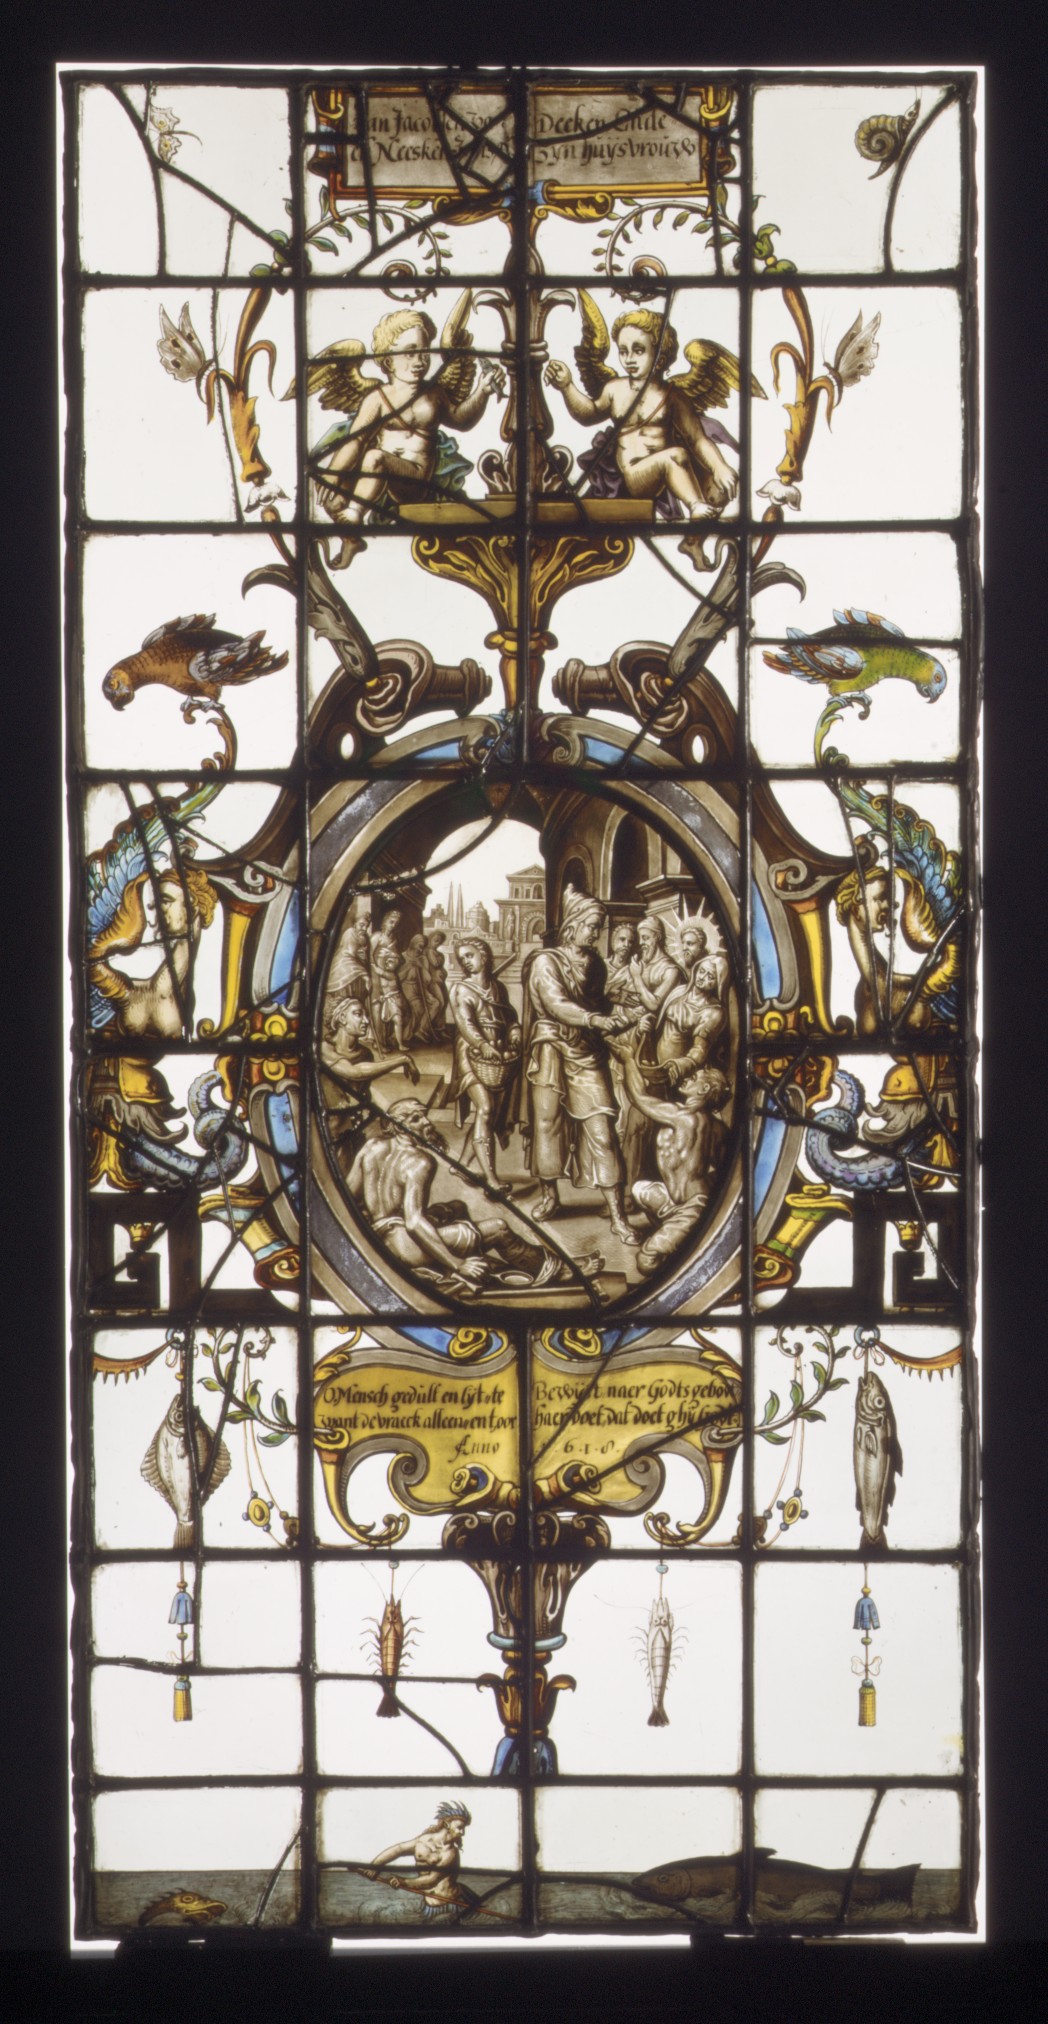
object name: panel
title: Feeding the Hungry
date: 1618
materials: glass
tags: birds,men,women,putti,fish